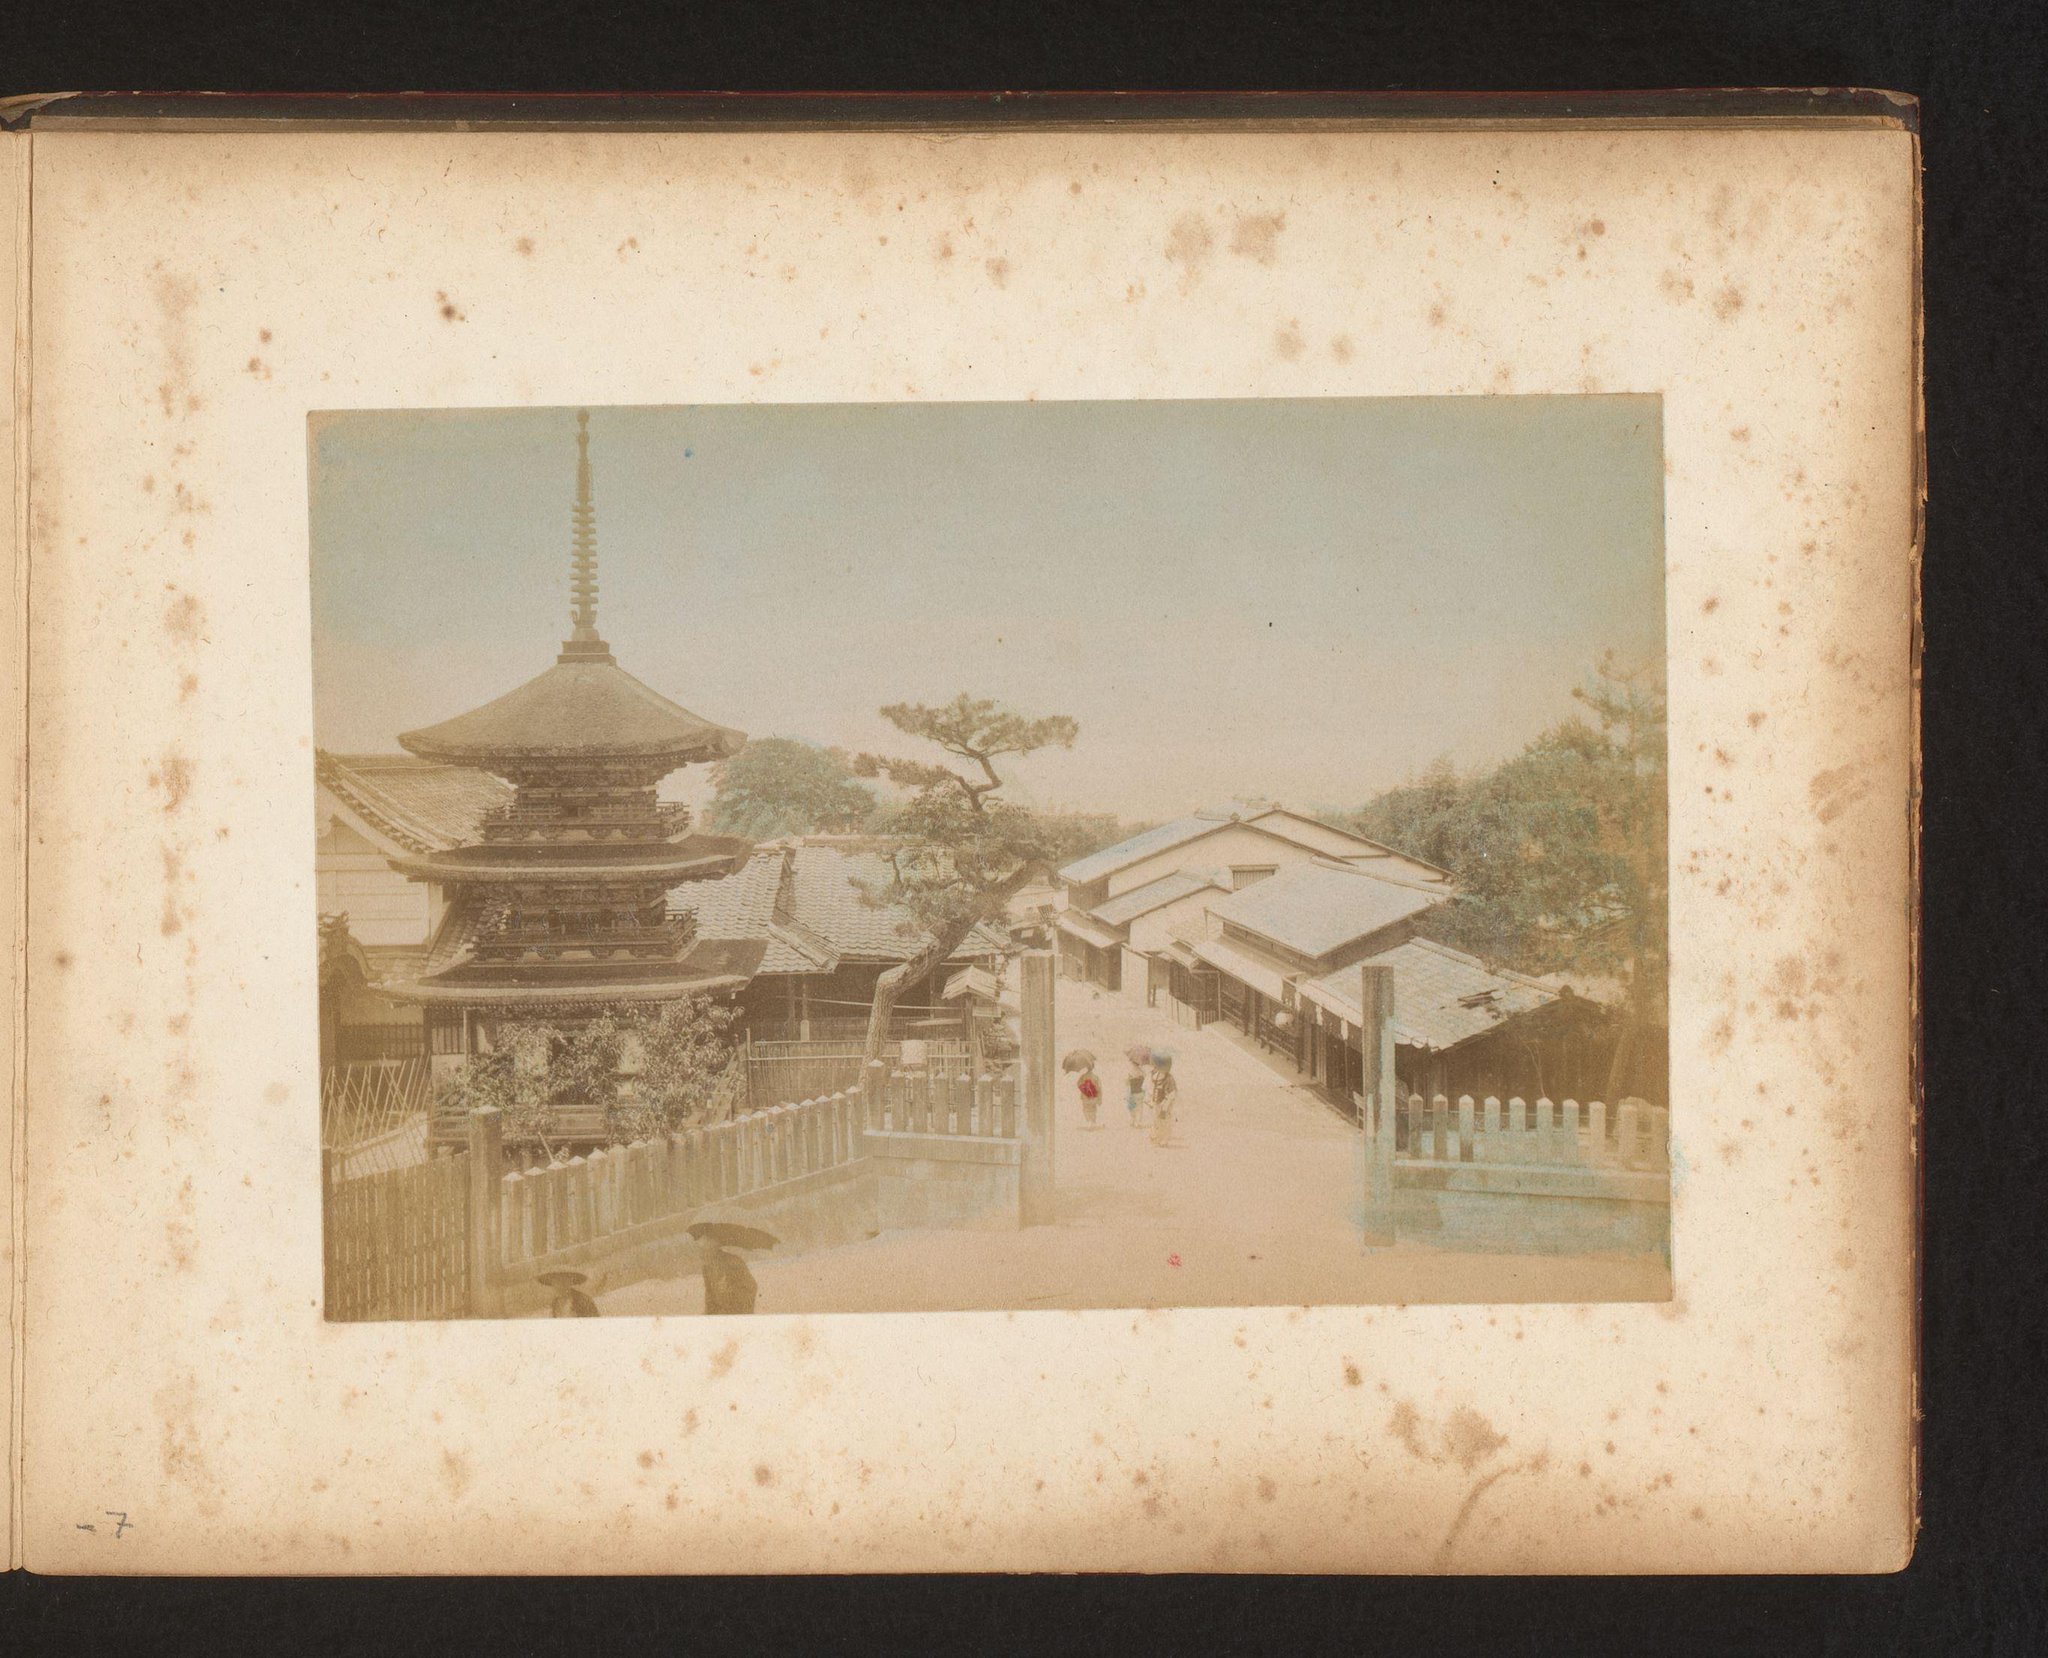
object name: album leaf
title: Gezicht op een dorp in Japan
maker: Anonymous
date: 1851-1900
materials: paper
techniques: albumen print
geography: japan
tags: village, japan